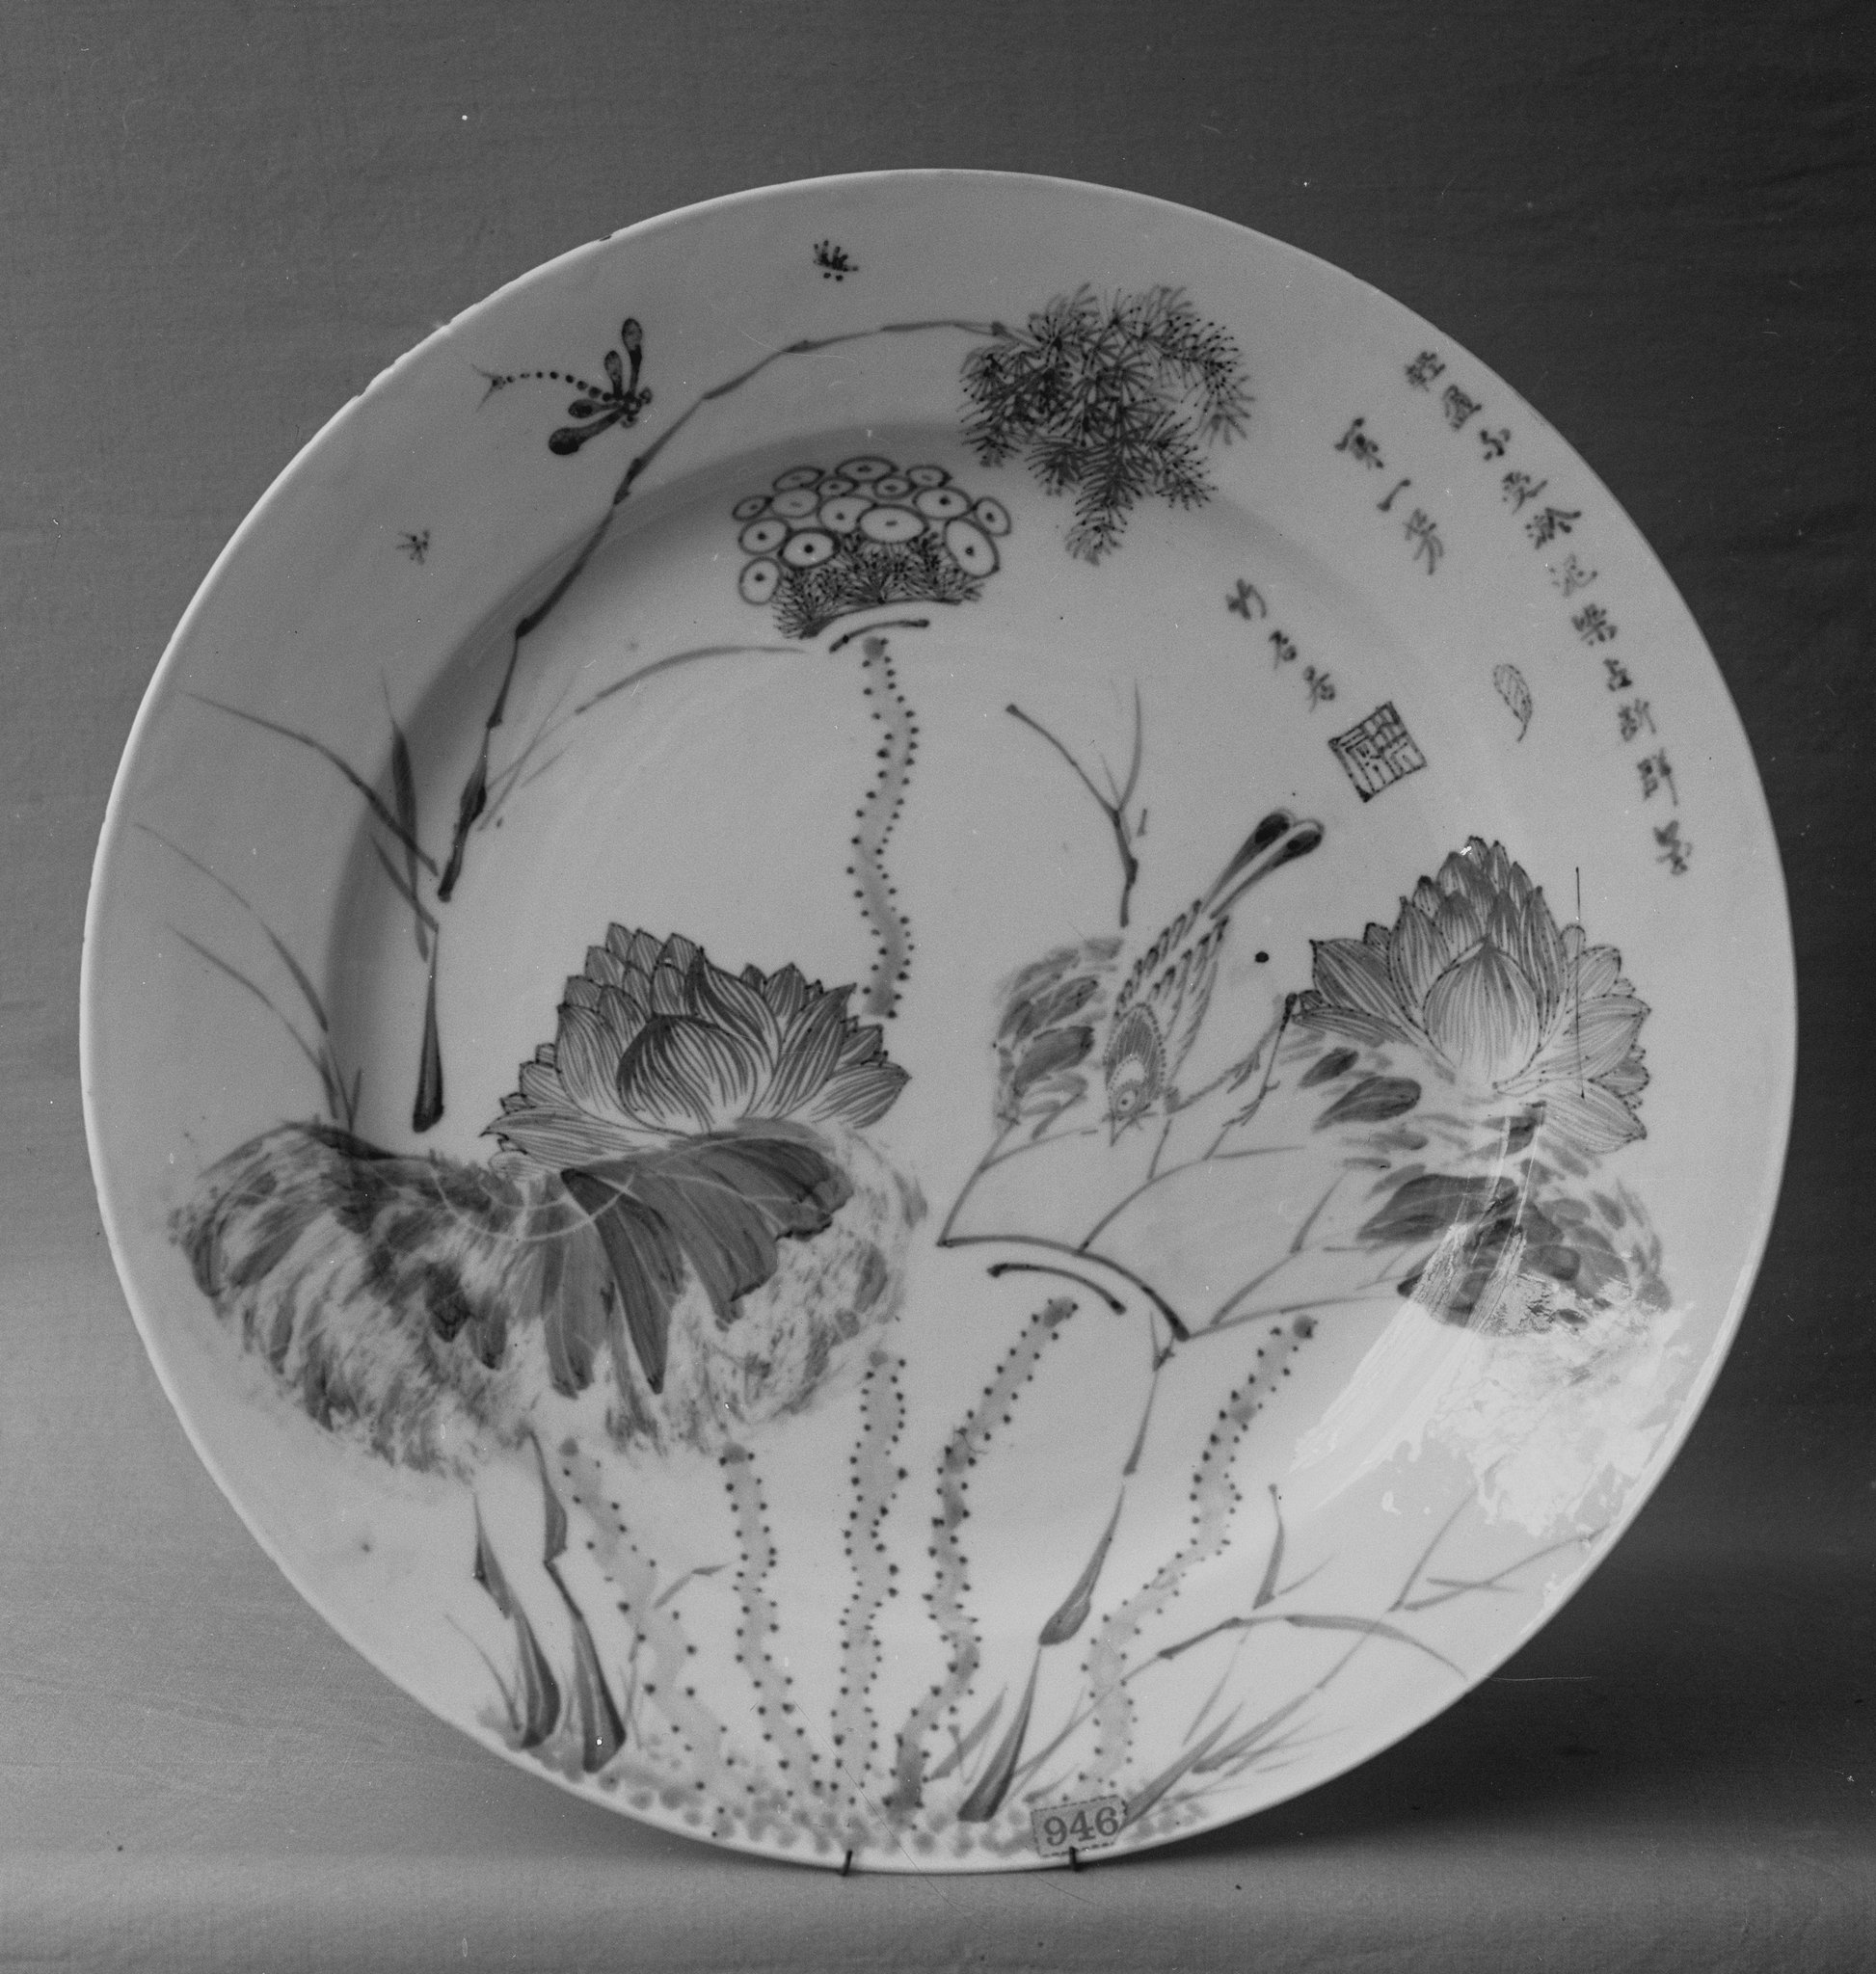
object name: plate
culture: chinese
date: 1701-1733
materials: porcelain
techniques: painting, underglaze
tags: birds,flowers